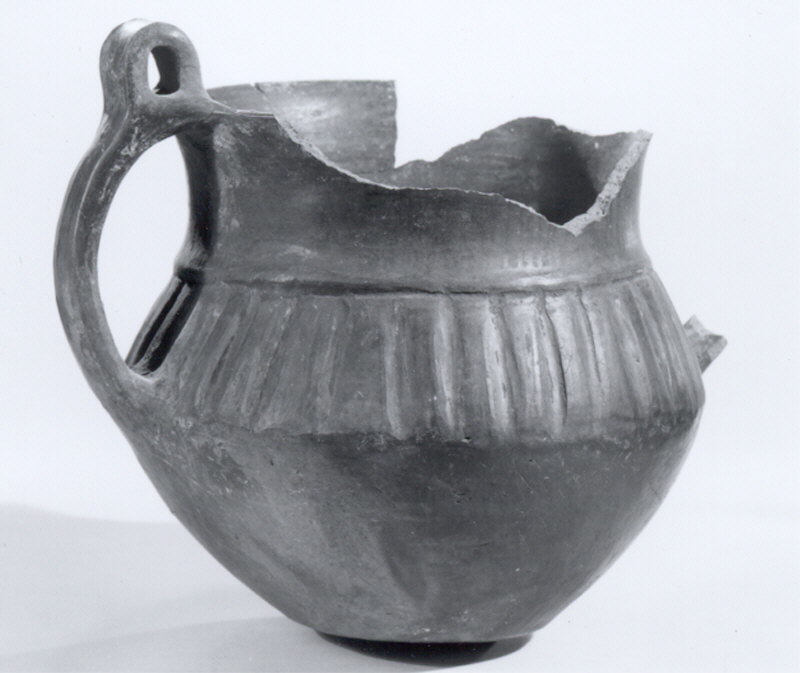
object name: pot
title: Handled "palace ware" pot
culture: iranian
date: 900-801 BCE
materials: ceramic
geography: iran